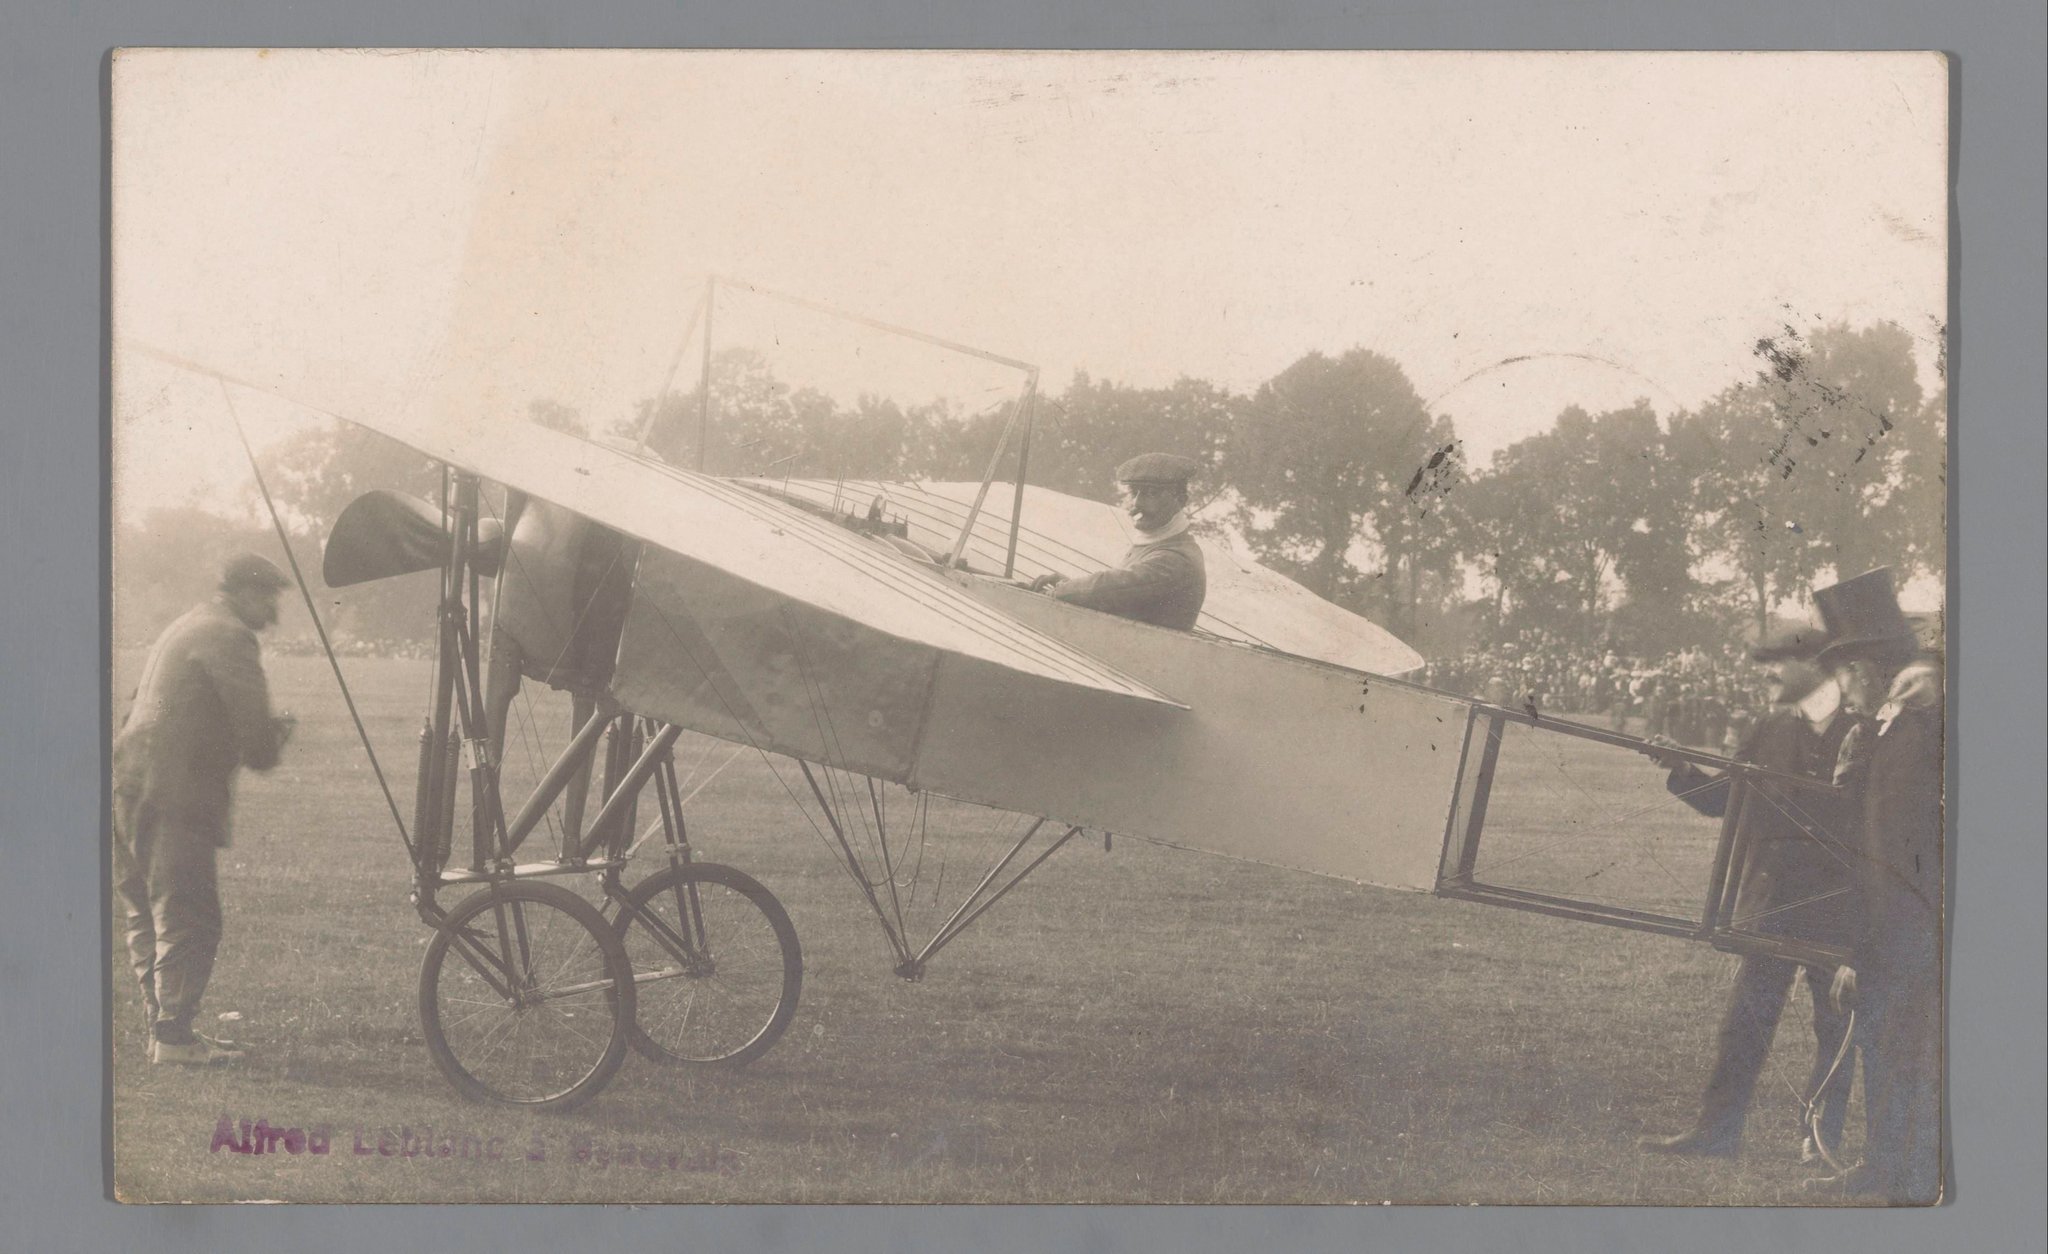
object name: ansichtkaart, prentbriefkaart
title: Portret van een onbekende vliegenier in een vliegtuig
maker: roger gatelet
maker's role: fotograaf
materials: photographic support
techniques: gelatin silver print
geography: france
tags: aircraft, aeroplane, pilot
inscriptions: inscription: ‘Echange cartes sports (...) Milders, Clameretten, 16, Delft Hollande’, inscription: ‘Alfred Leblanc a Beauvais’